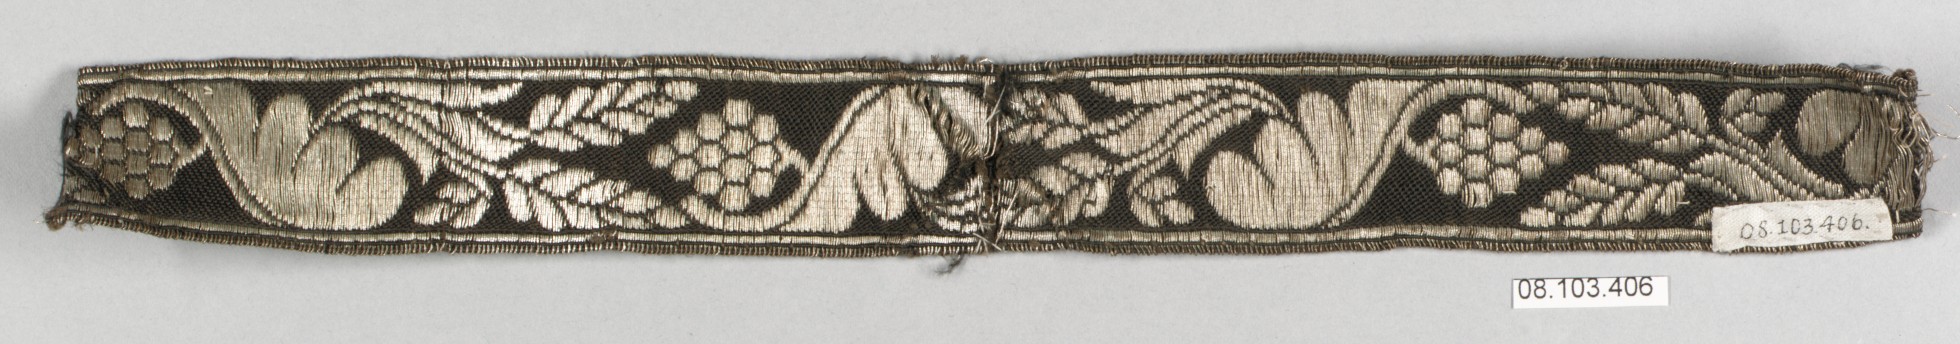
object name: galloon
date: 1701-1900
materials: metal thread, silk